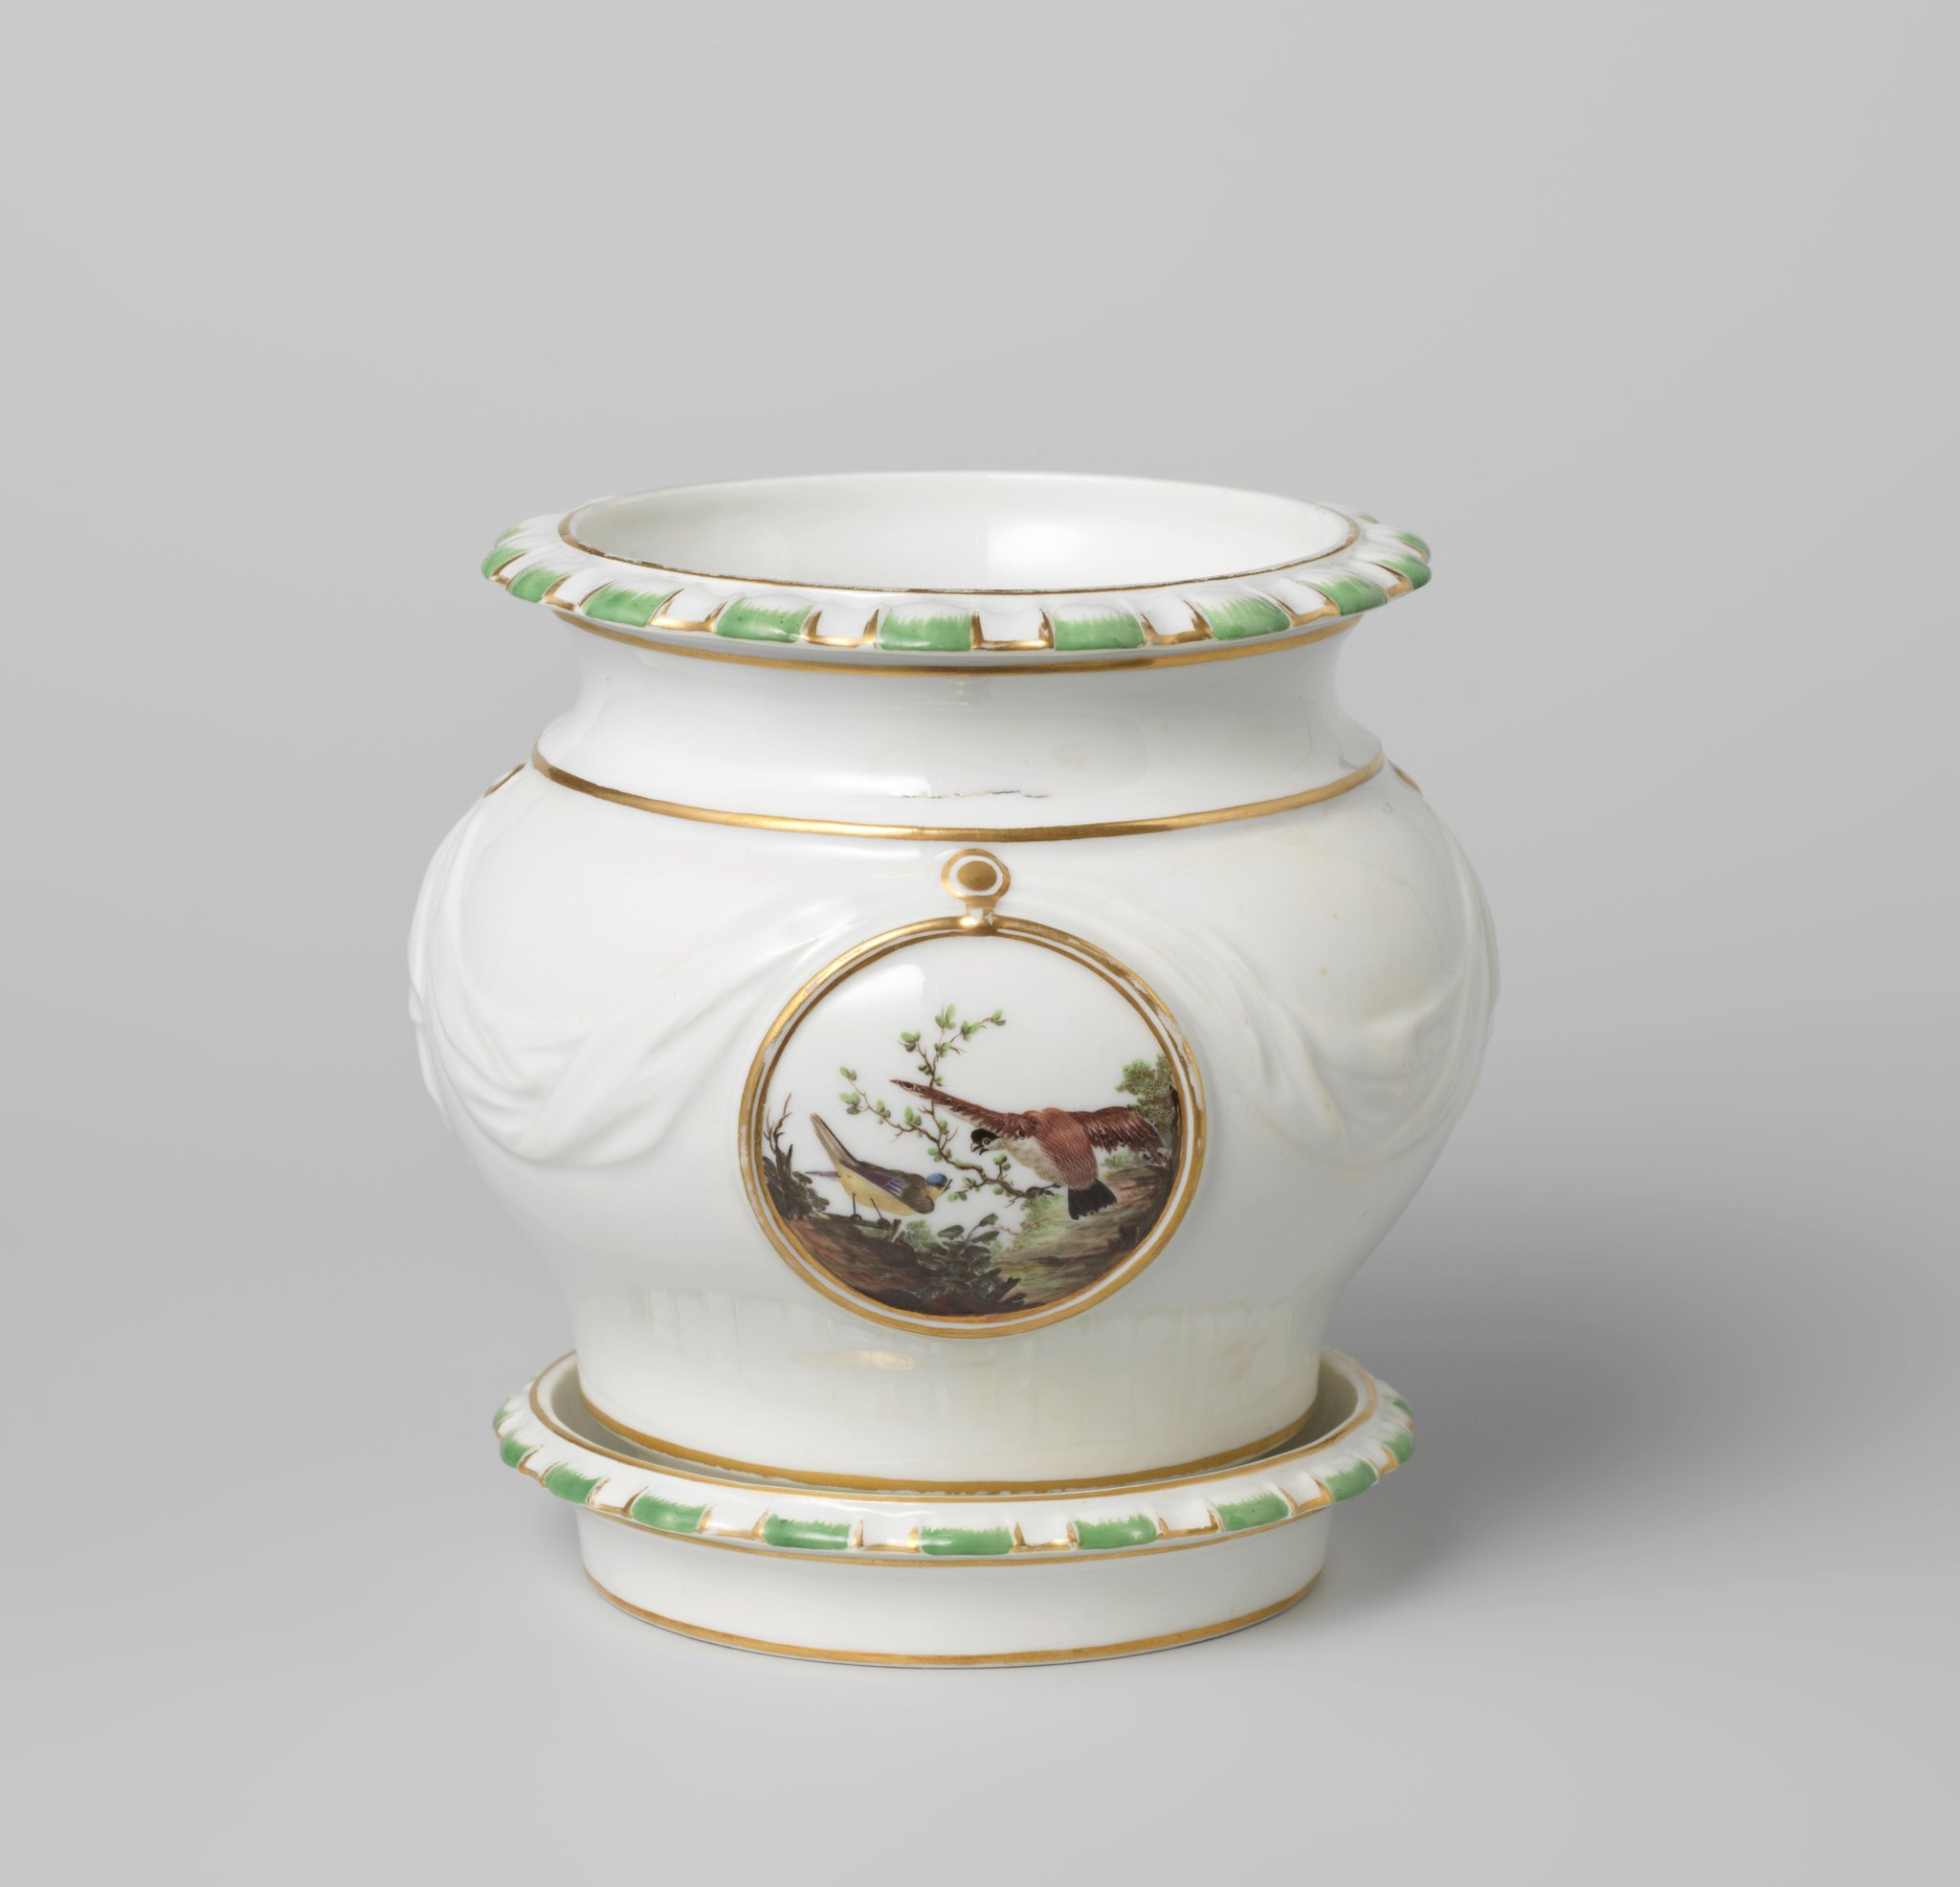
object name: platter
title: Bloempot op onderschotel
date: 1784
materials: porcelain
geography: loosdrecht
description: Two flower pots and stands. Porcelain. Loosdrecht and Ouder-Amstel, c. 1784 - 1790. Factory under the direction of Friedrich Daeuber. Baronesse J.P.G. van Brakell tot den Brakell bequest, 1904.